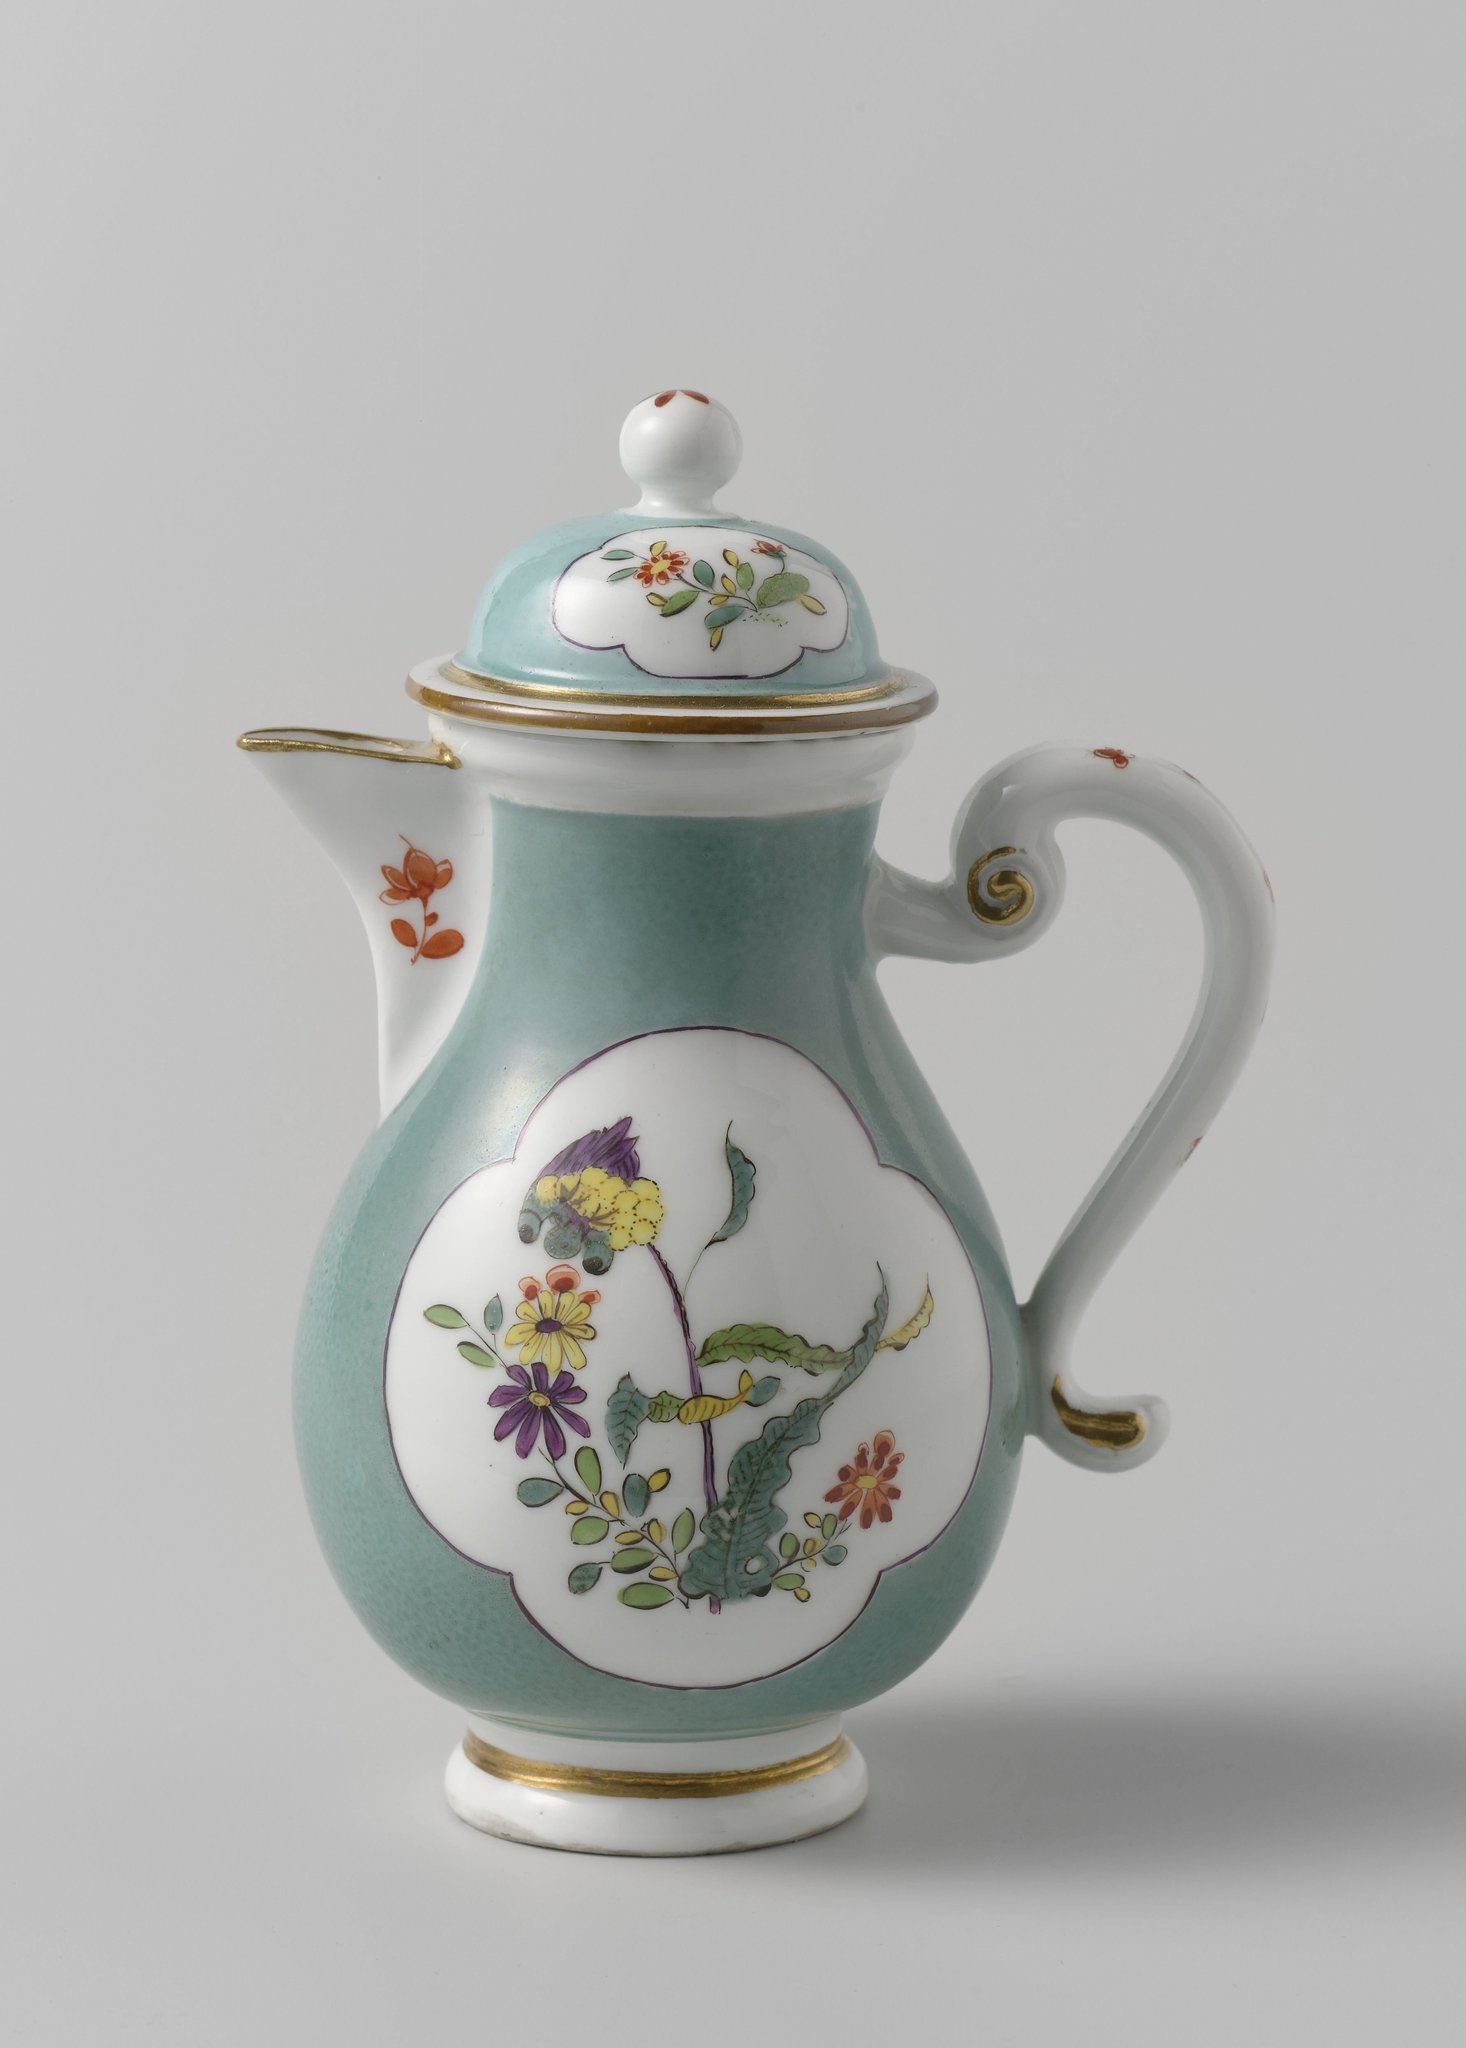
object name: lid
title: Deksel van melkkan, veelkleurig beschilderd met bloemtakken op een zeegroene fond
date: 1737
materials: porcelain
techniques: painted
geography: meissen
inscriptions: factory mark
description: Deksel van melkkan, van veelkleurig beschilderd porselein. Op de dekselknop een rozet. Enkele delen zijn verguld.